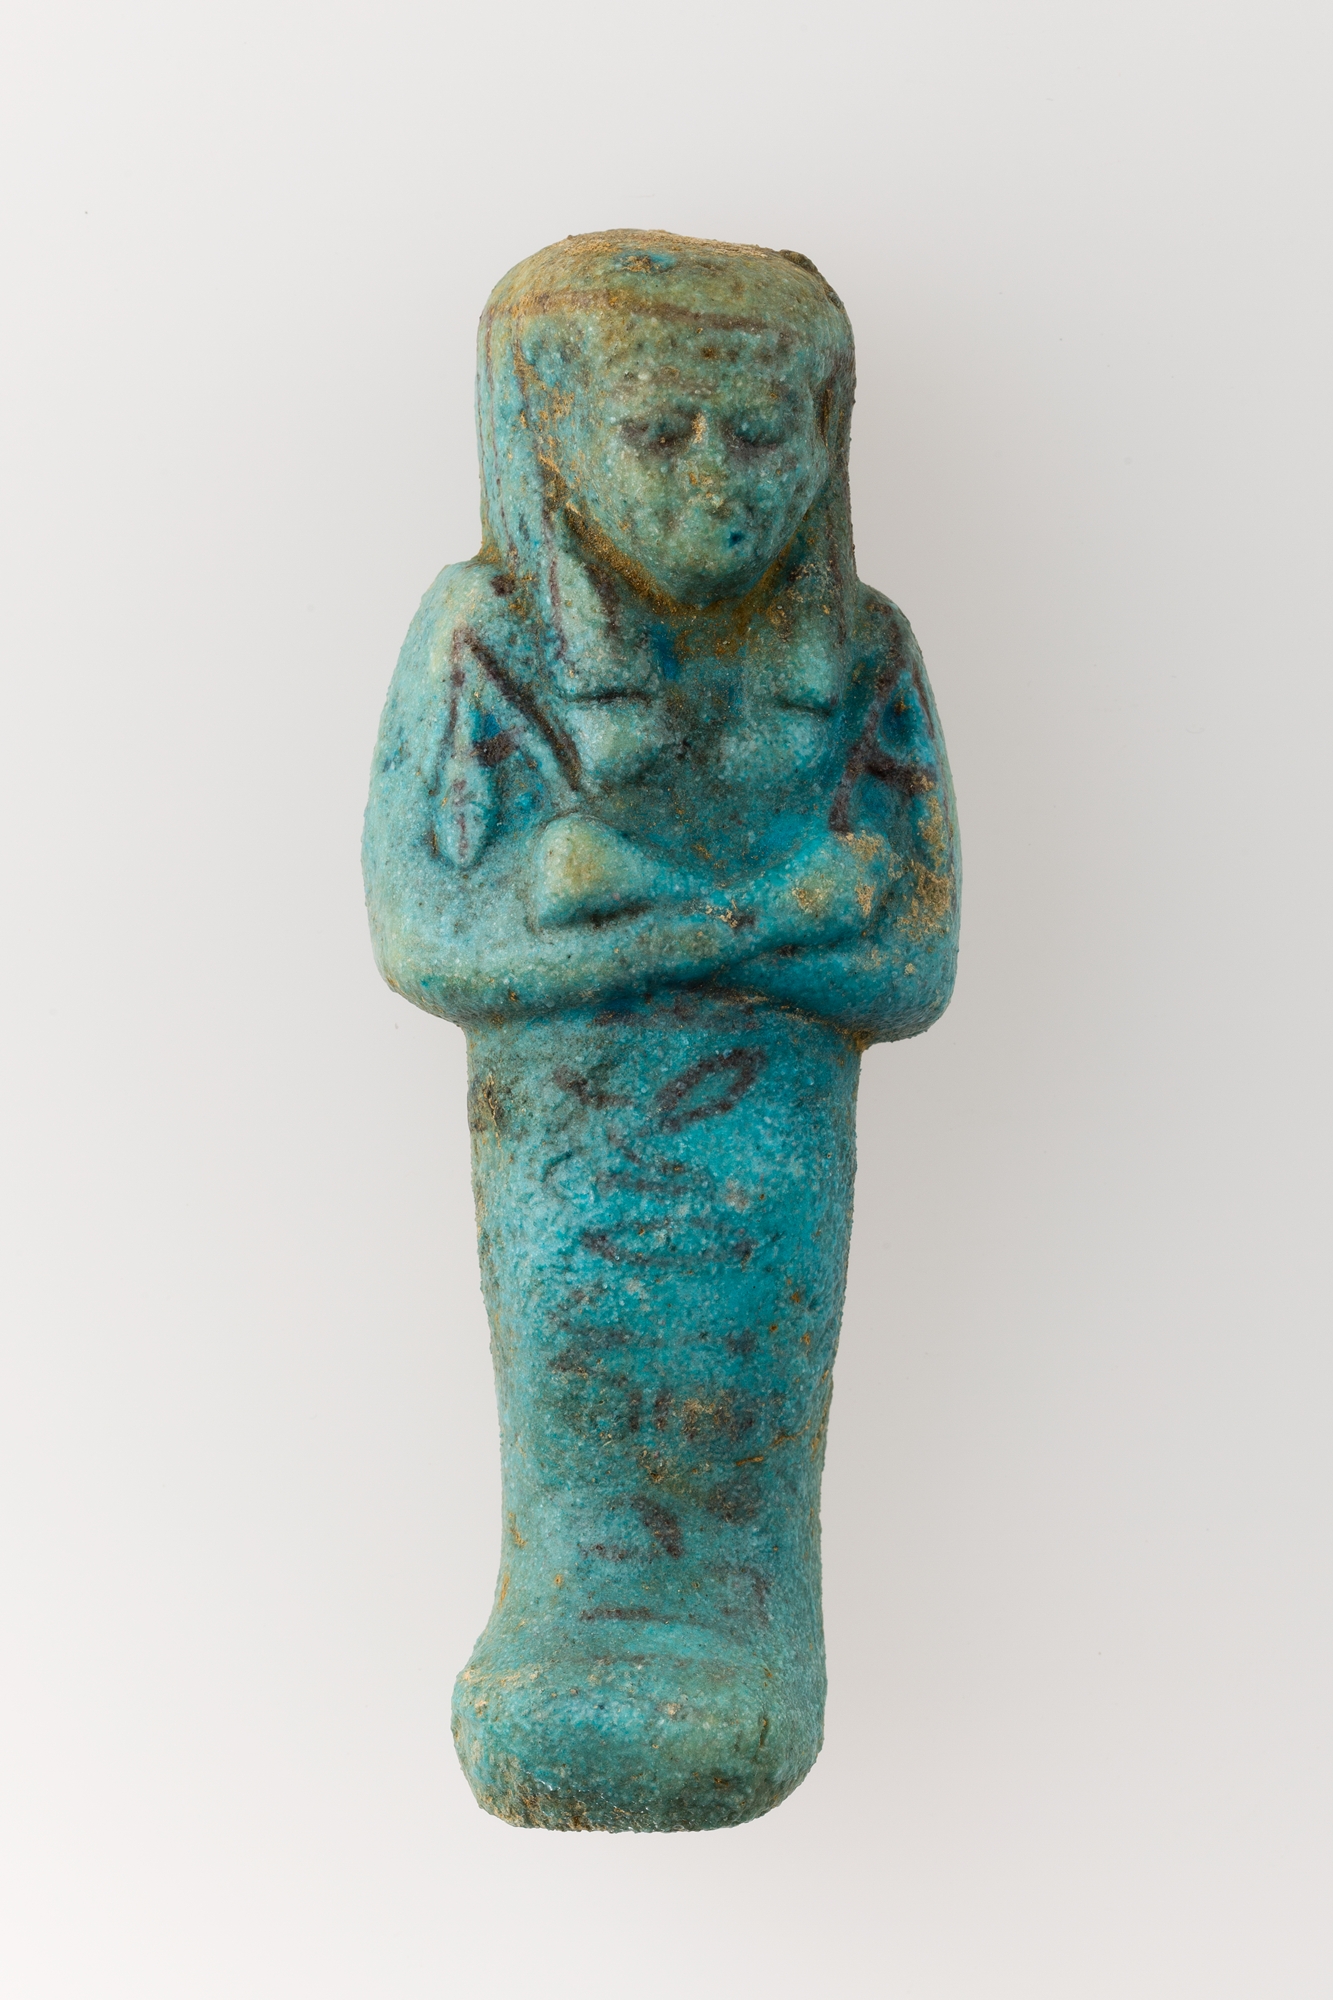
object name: shabti, henettawy c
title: Worker Shabti of Henettawy (C), Daughter of Isetemkheb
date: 990-970 BCE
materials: faience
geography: egypt